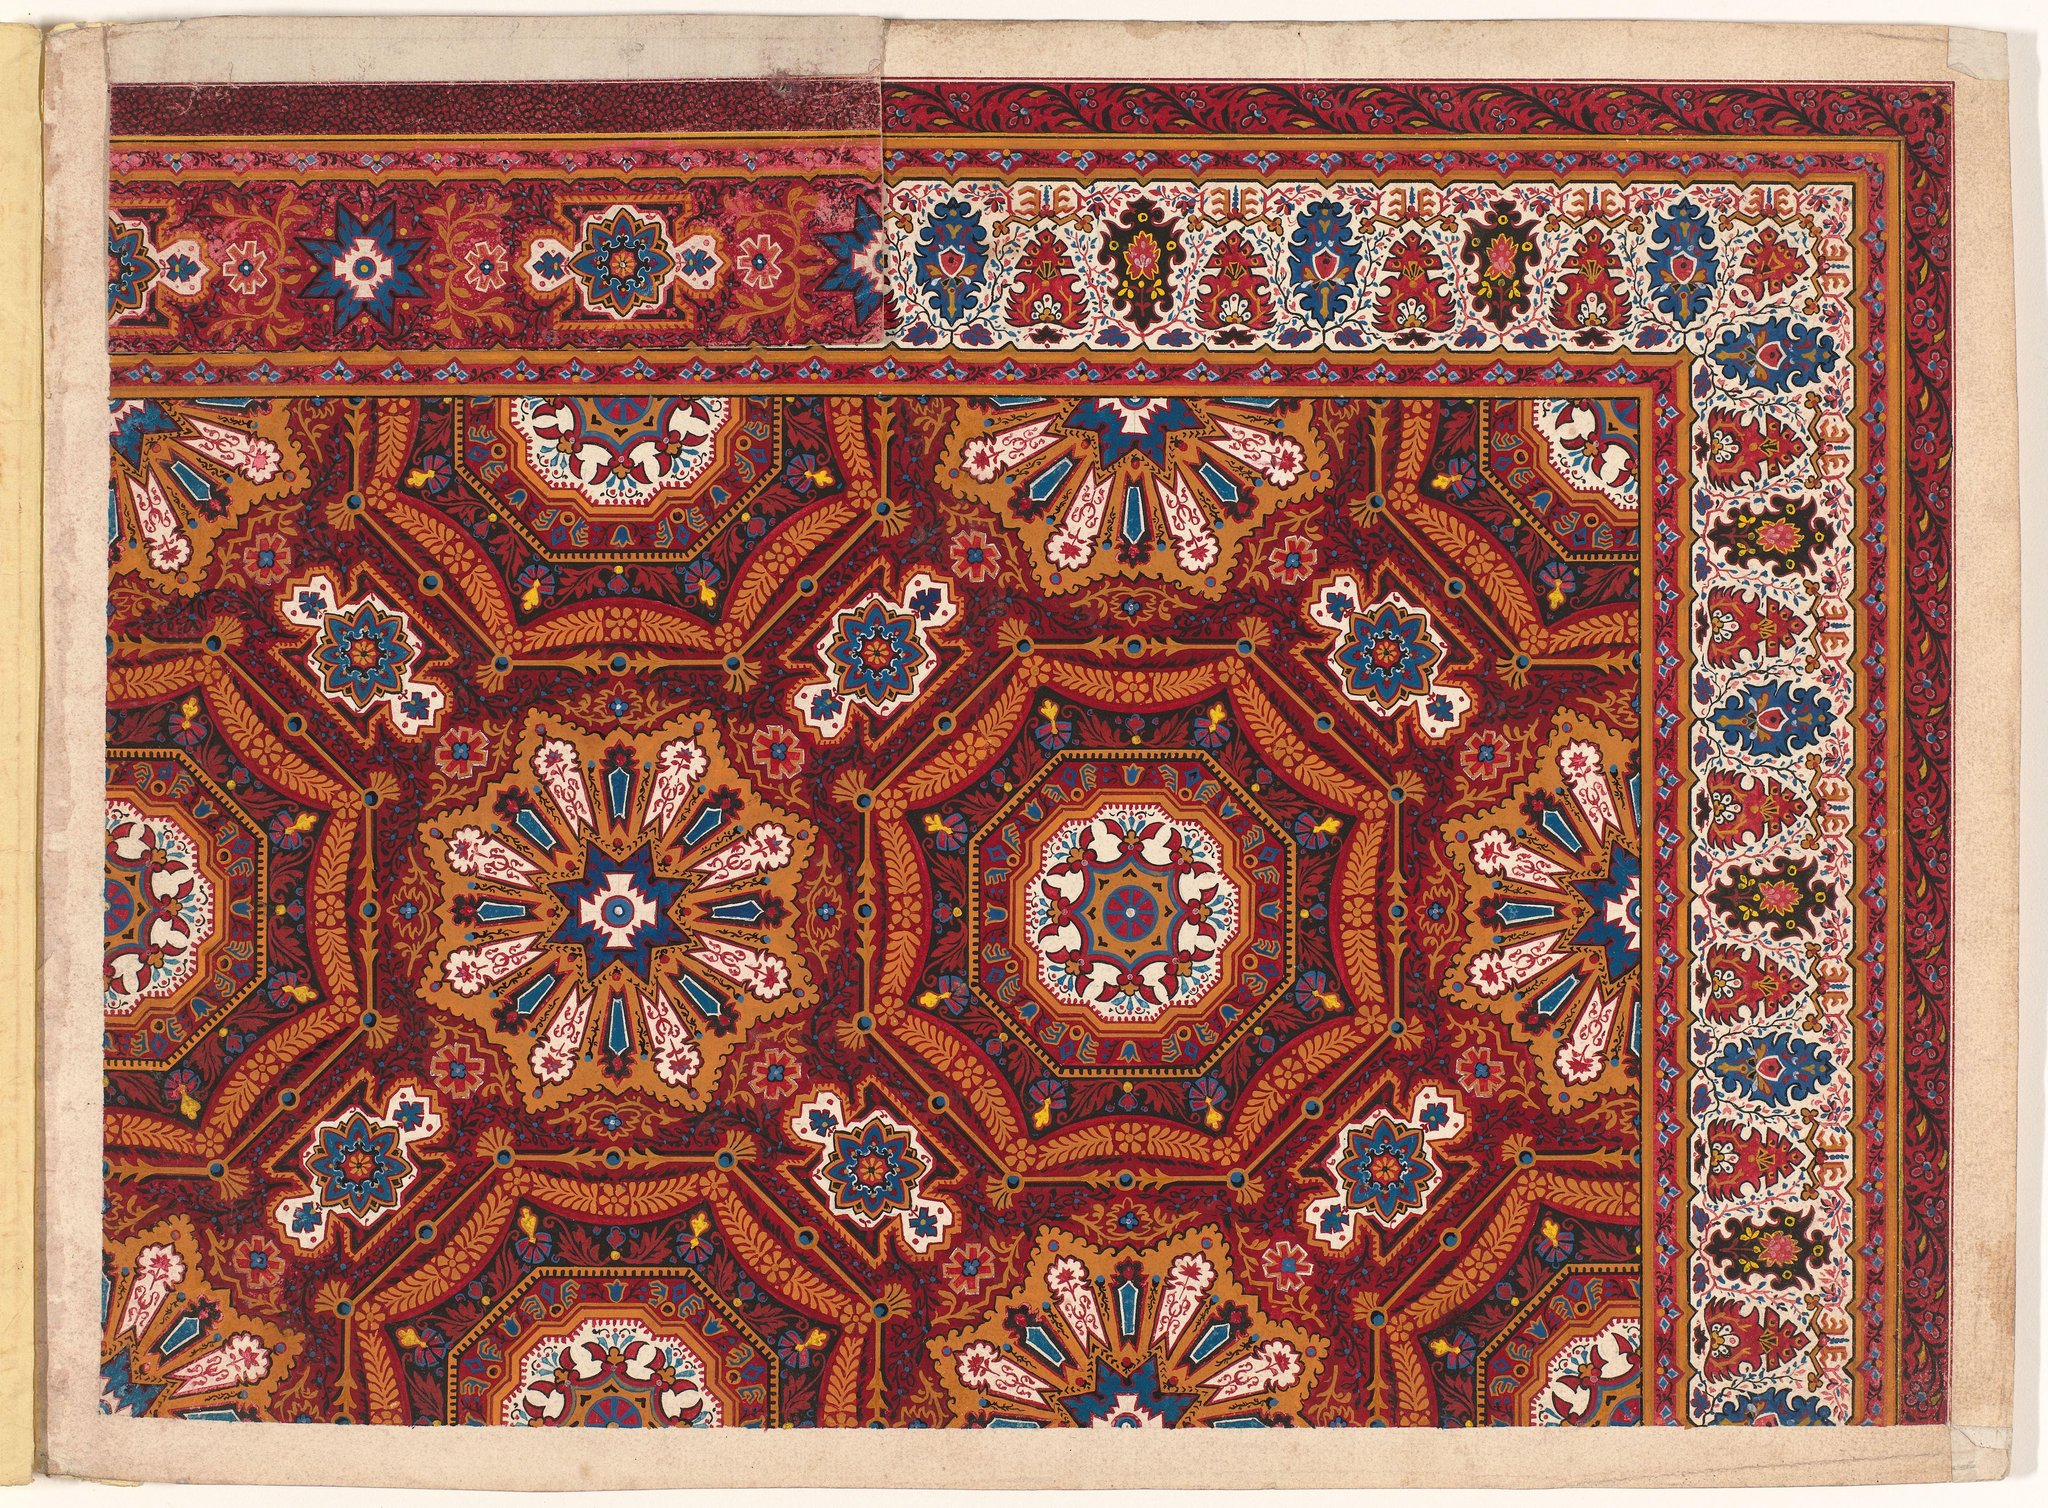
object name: drawing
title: Ontwerp voor een tapijt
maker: Anonymous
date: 1854-1864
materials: gouache, paper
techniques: brush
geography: amsterdam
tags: ornaments ~ art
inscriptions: retailer's mark: ‘JHS.’, inscription: ‘C s.’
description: De presentatietekeningen BK-1971-77-1 t/m 86 zijn kopieën van de originele ontwerptekeningen. Ze werden gemaakt voor vertegenwoordigers van bijvoorbeeld magazijnen, die ze aan hun klanten konden tonen. De meeste tekeningen tonen een kwart van het dessin inclusief rand, middenpartij (de zogenaamde grond of fond) en centraal medaillon. Door het gebruik van spiegels kan de illusie van het gehele tapijt worden opgeroepen. Een deel van de tekeningen heeft een alfabetische opeenvolgende letter als kenmerk, de andere groep een cijfer.Waarschijnlijk is de reeks dessins met een letter eerder samengesteld dan de genummerde tekeningen.